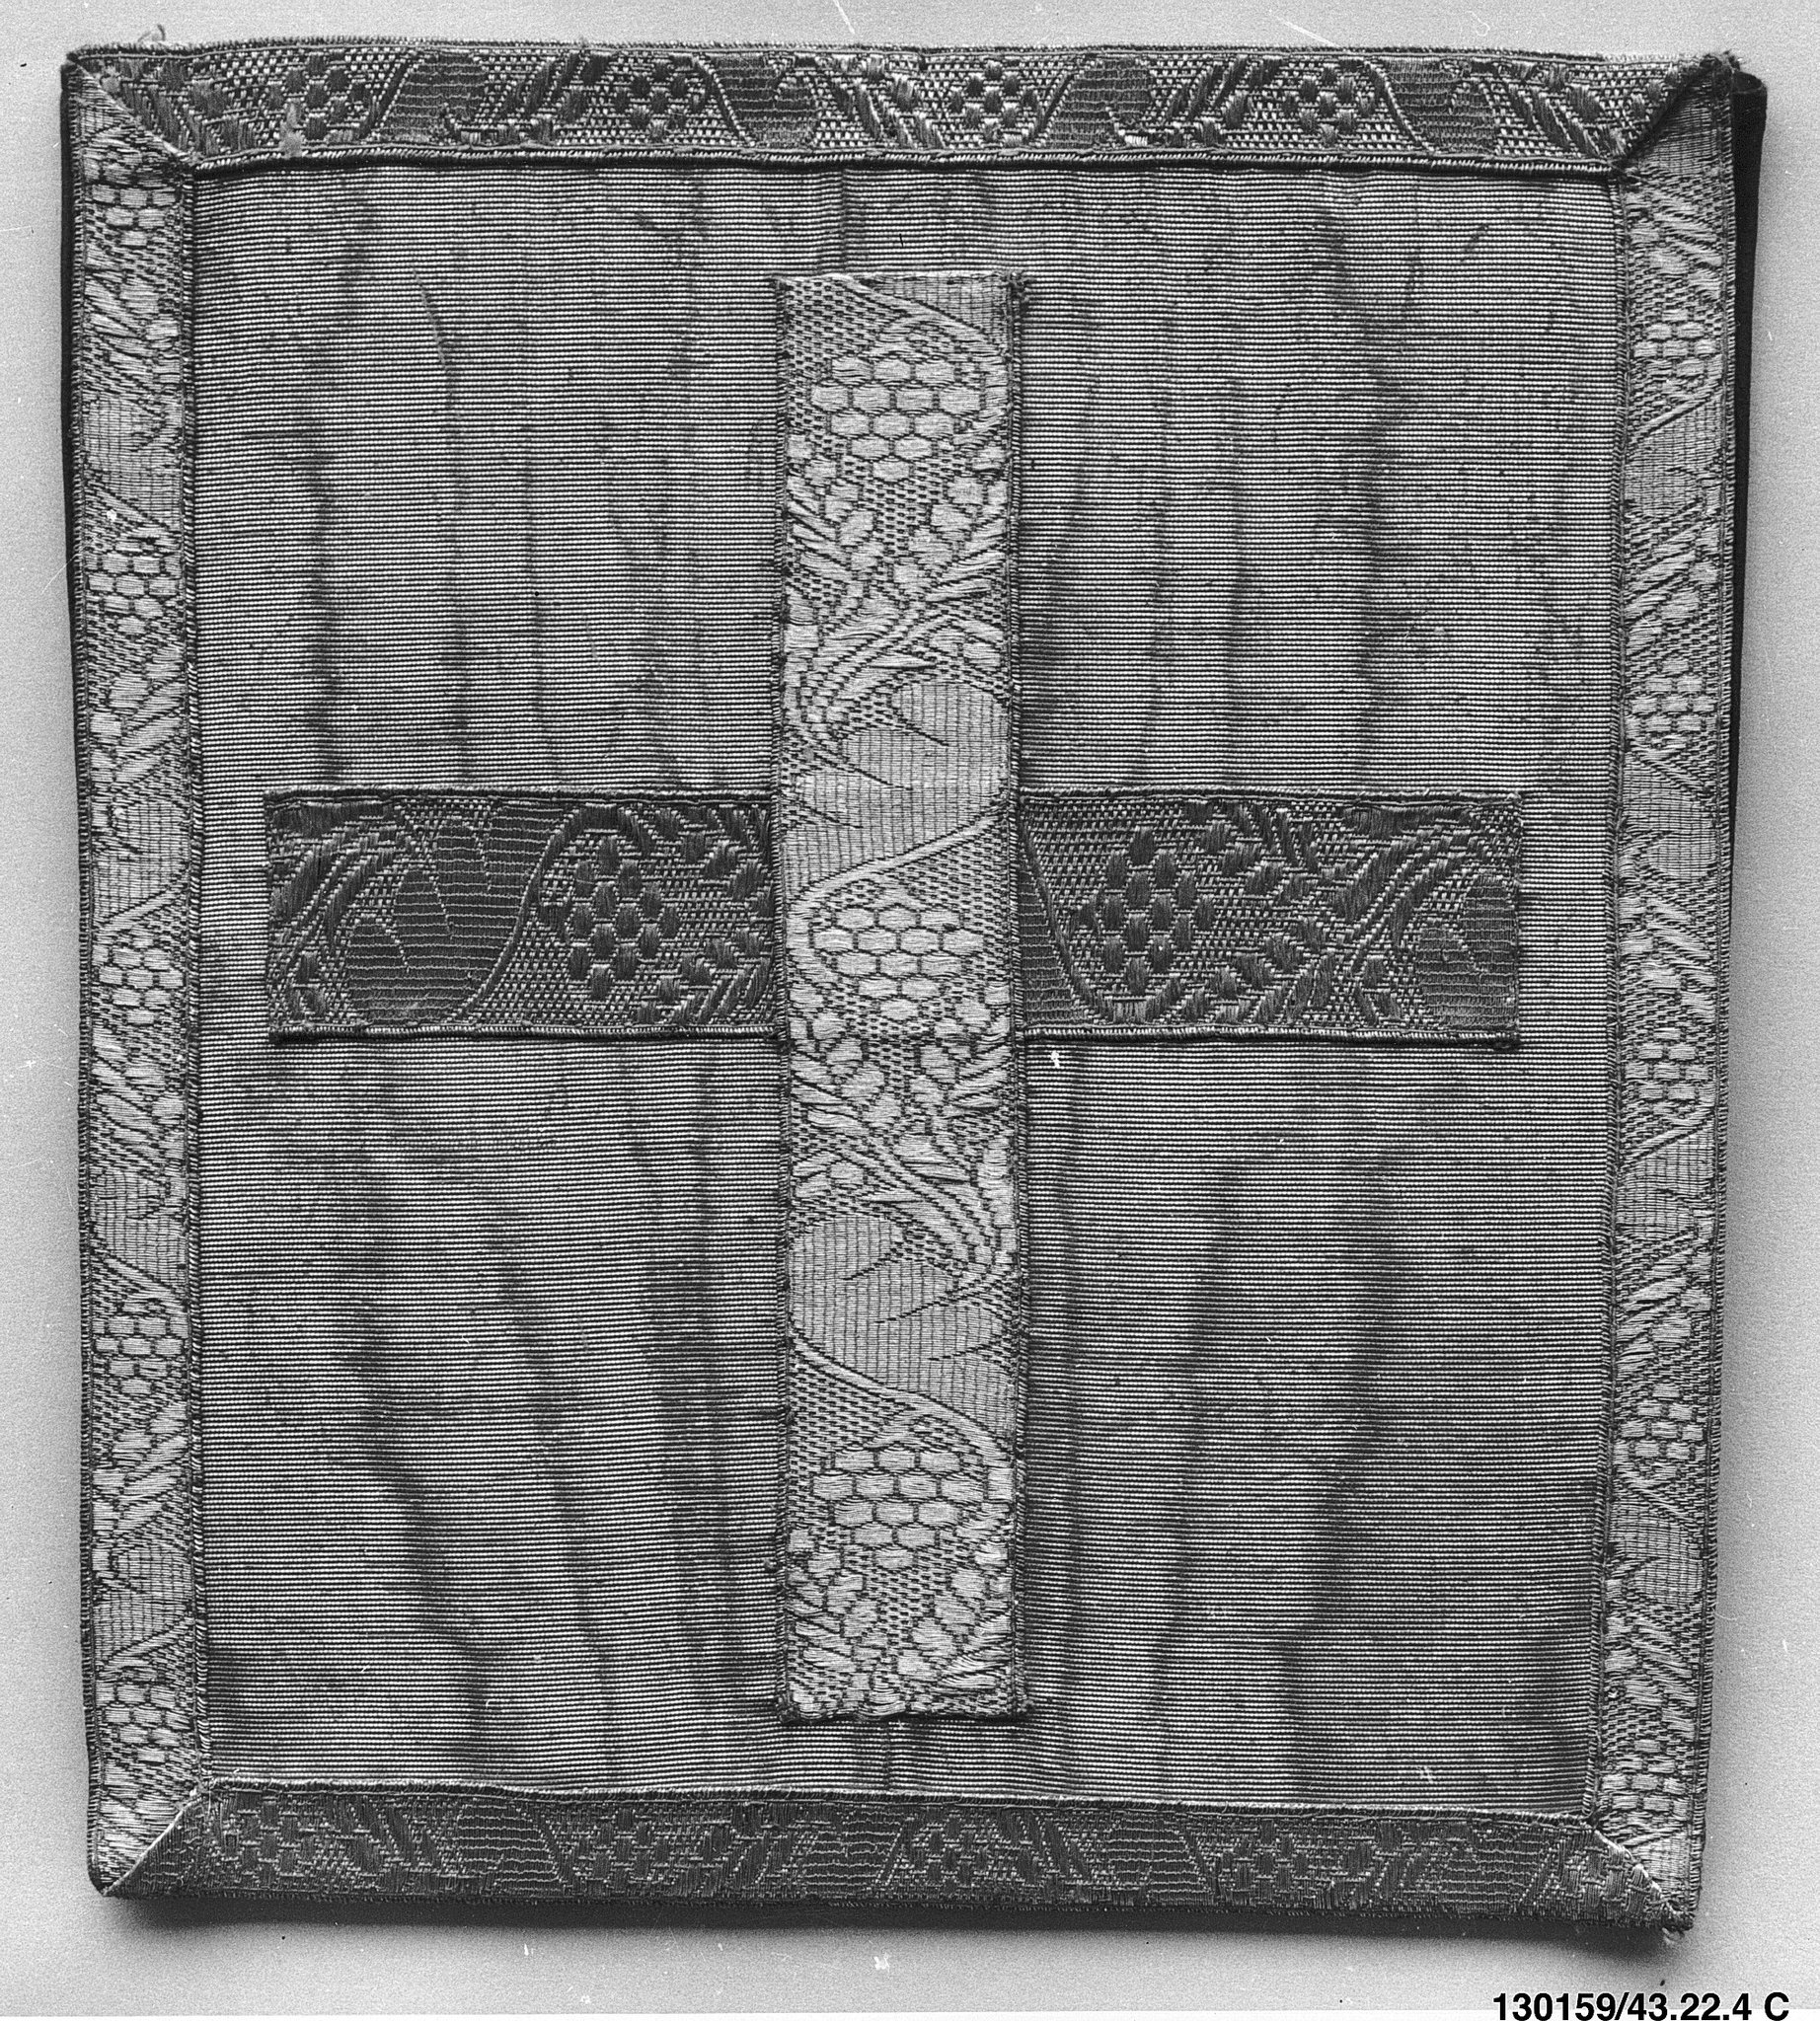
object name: burse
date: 1801-1900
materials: metal thread, silk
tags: cross